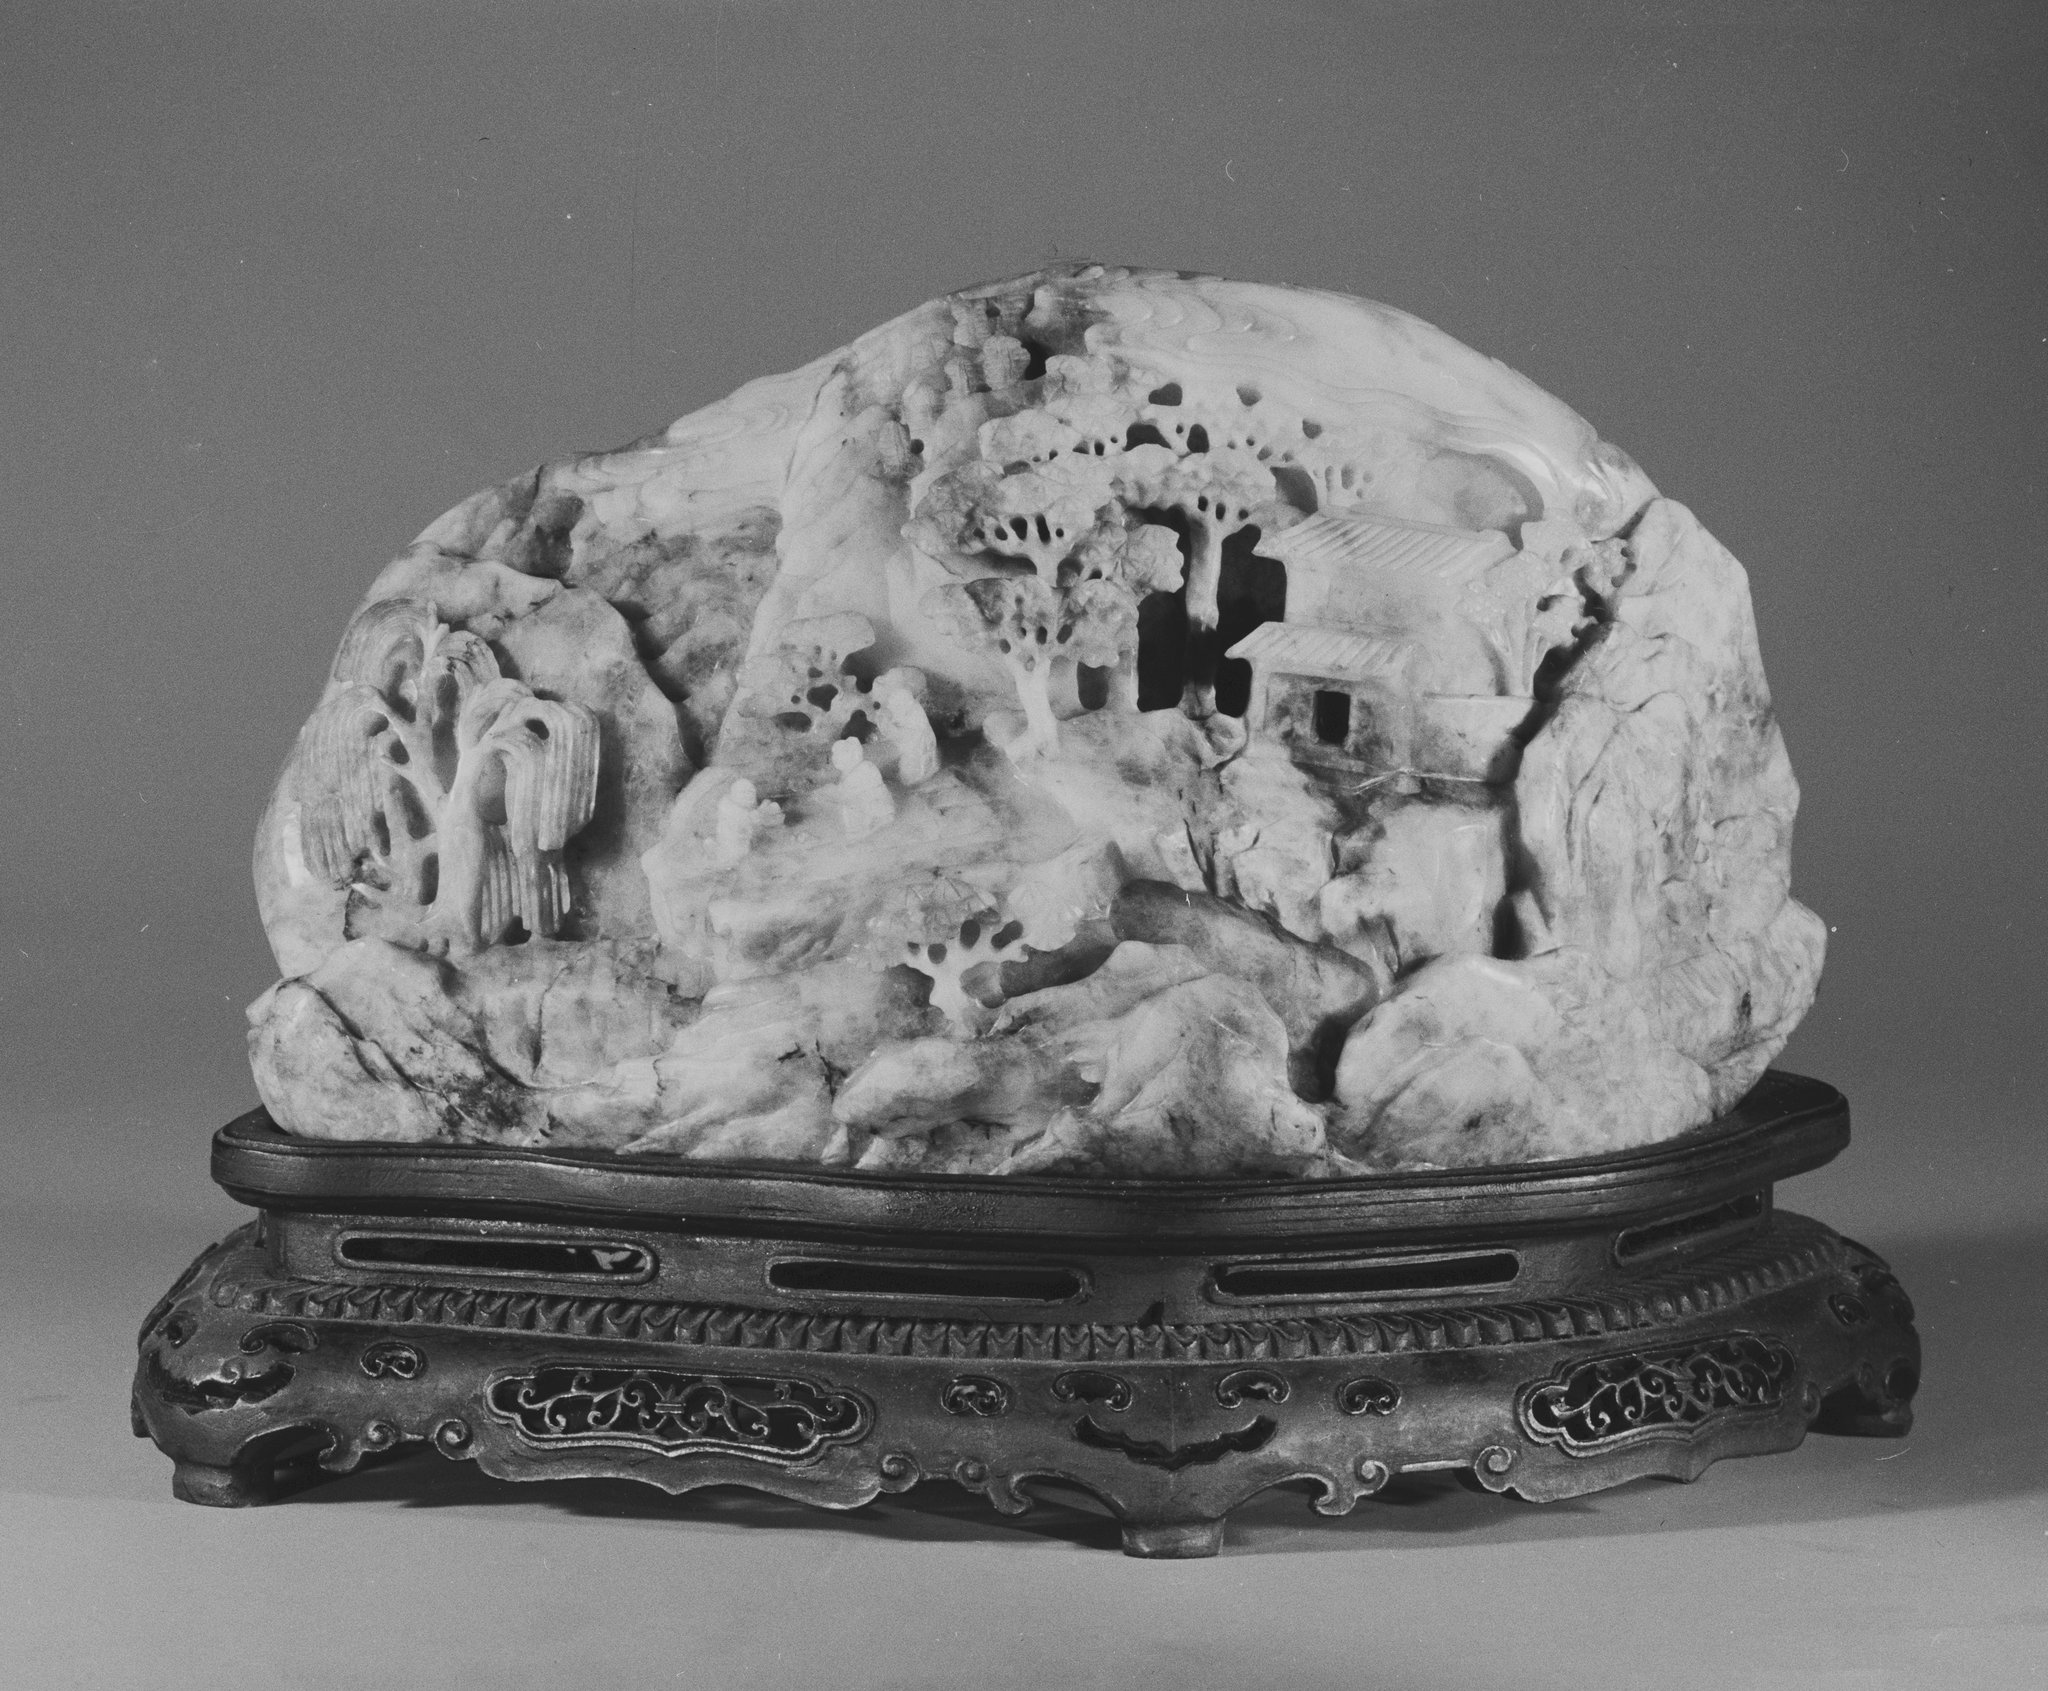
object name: relief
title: Mountain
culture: chinese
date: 1801-1900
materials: jade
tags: houses,mountains,trees